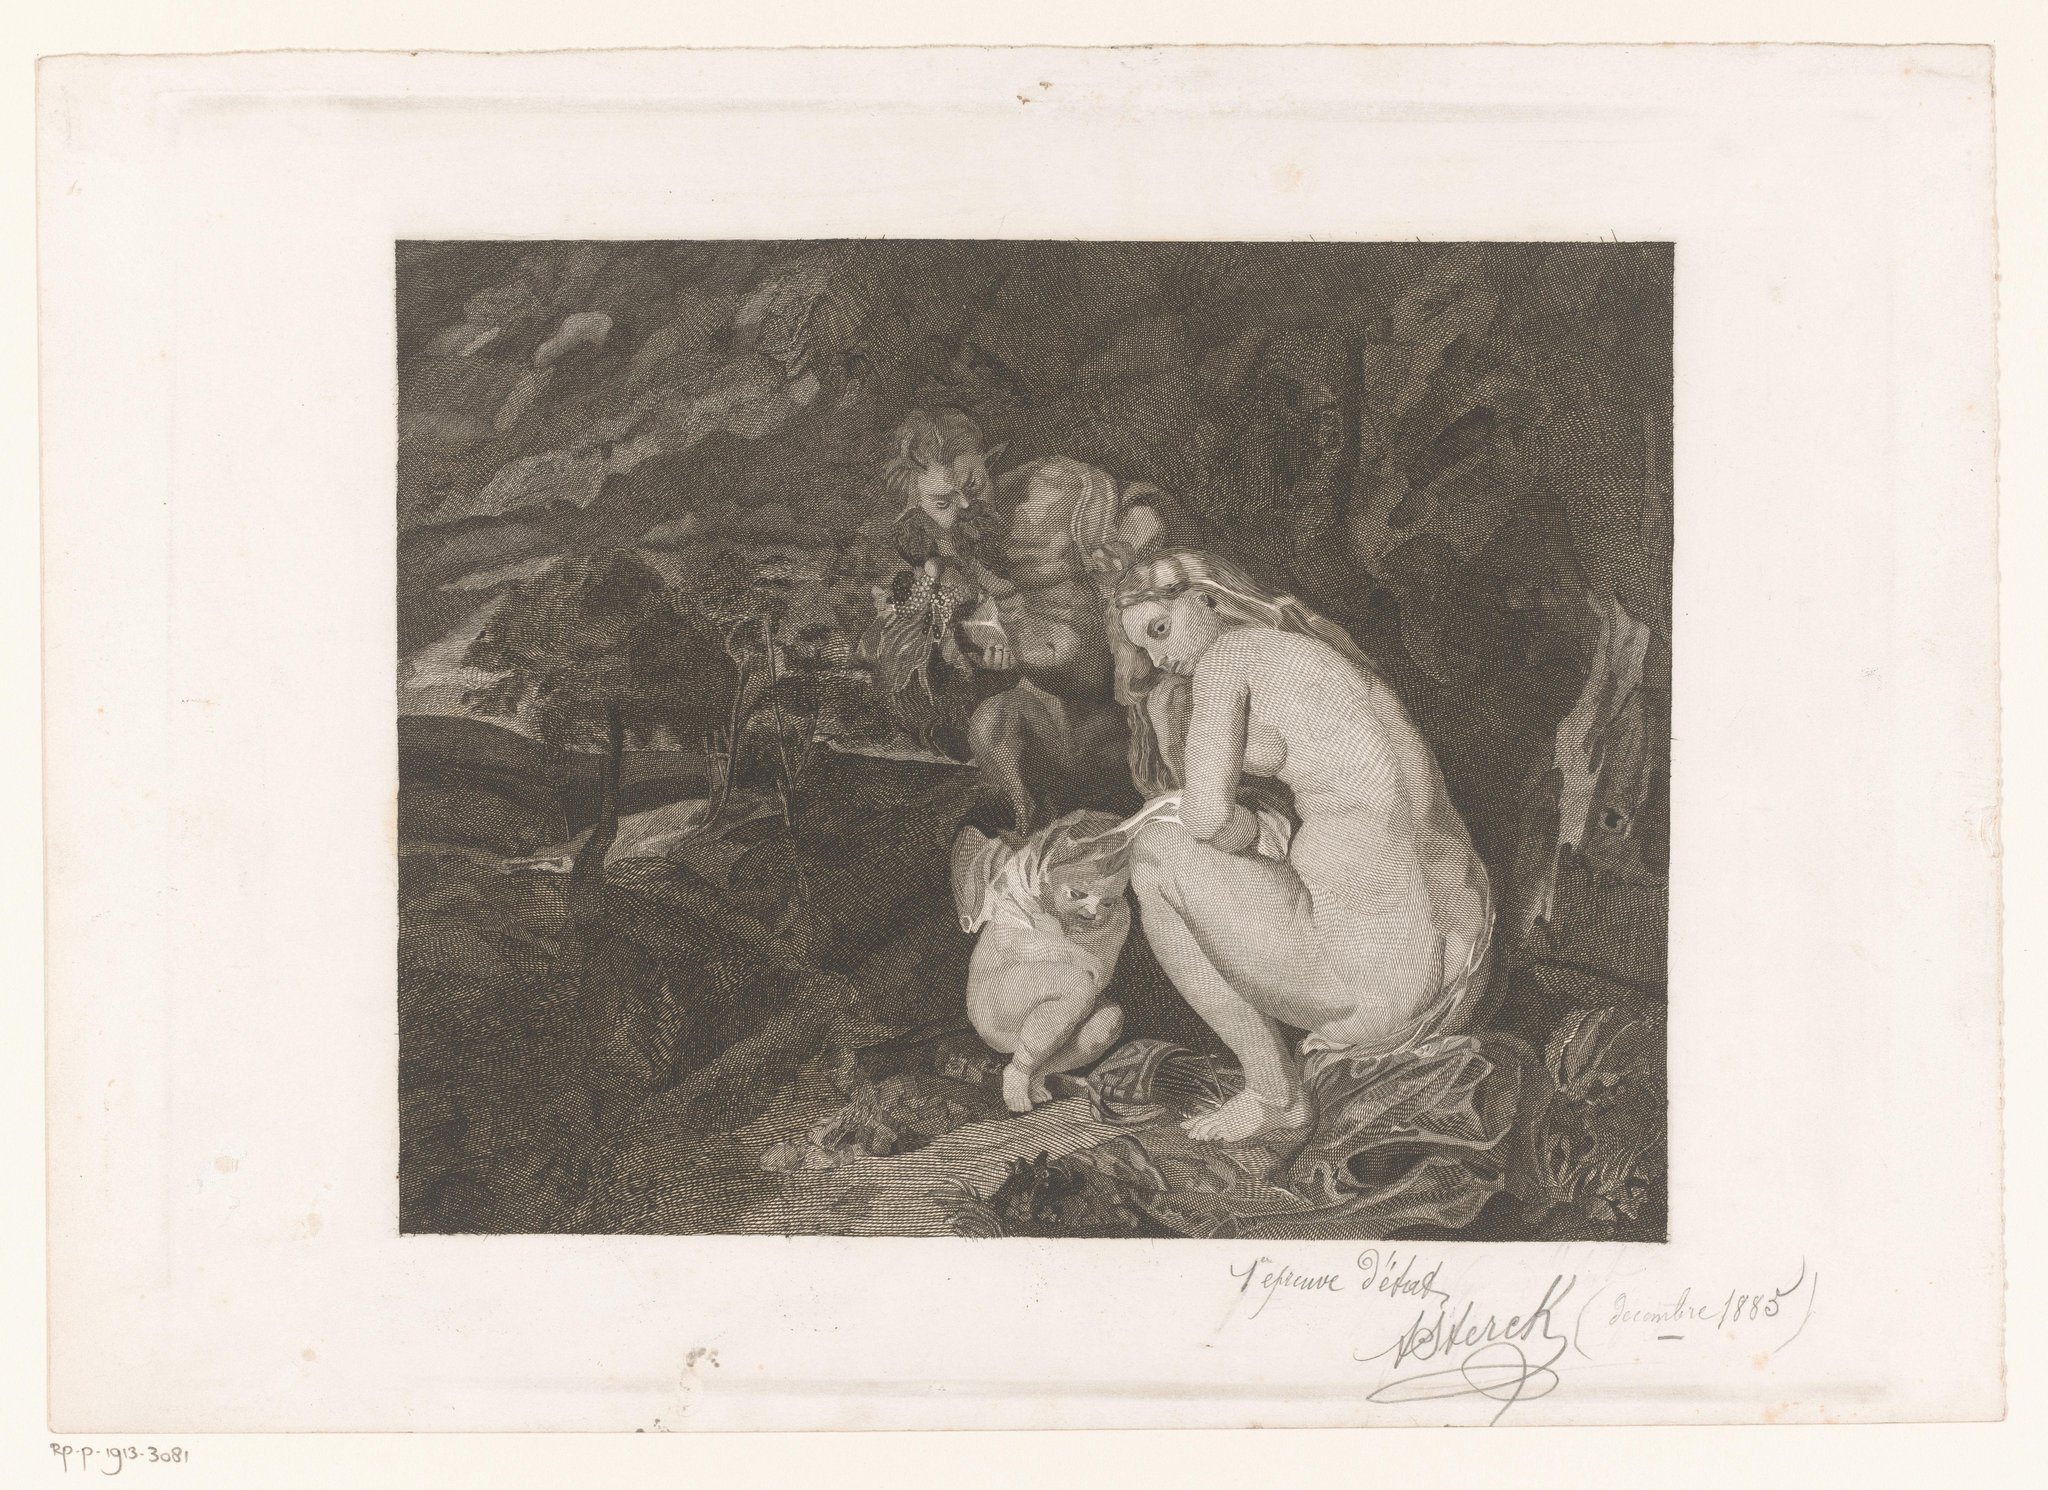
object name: print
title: Venus hurkt bij een faun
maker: arthur sterck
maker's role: print maker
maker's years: 1868-1897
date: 1812-1885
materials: paper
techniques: etching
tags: 'sine cerere et baccho friget venus'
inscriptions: collector's mark: Lugt 2228, annotation: ‘1er epreuve d'état’